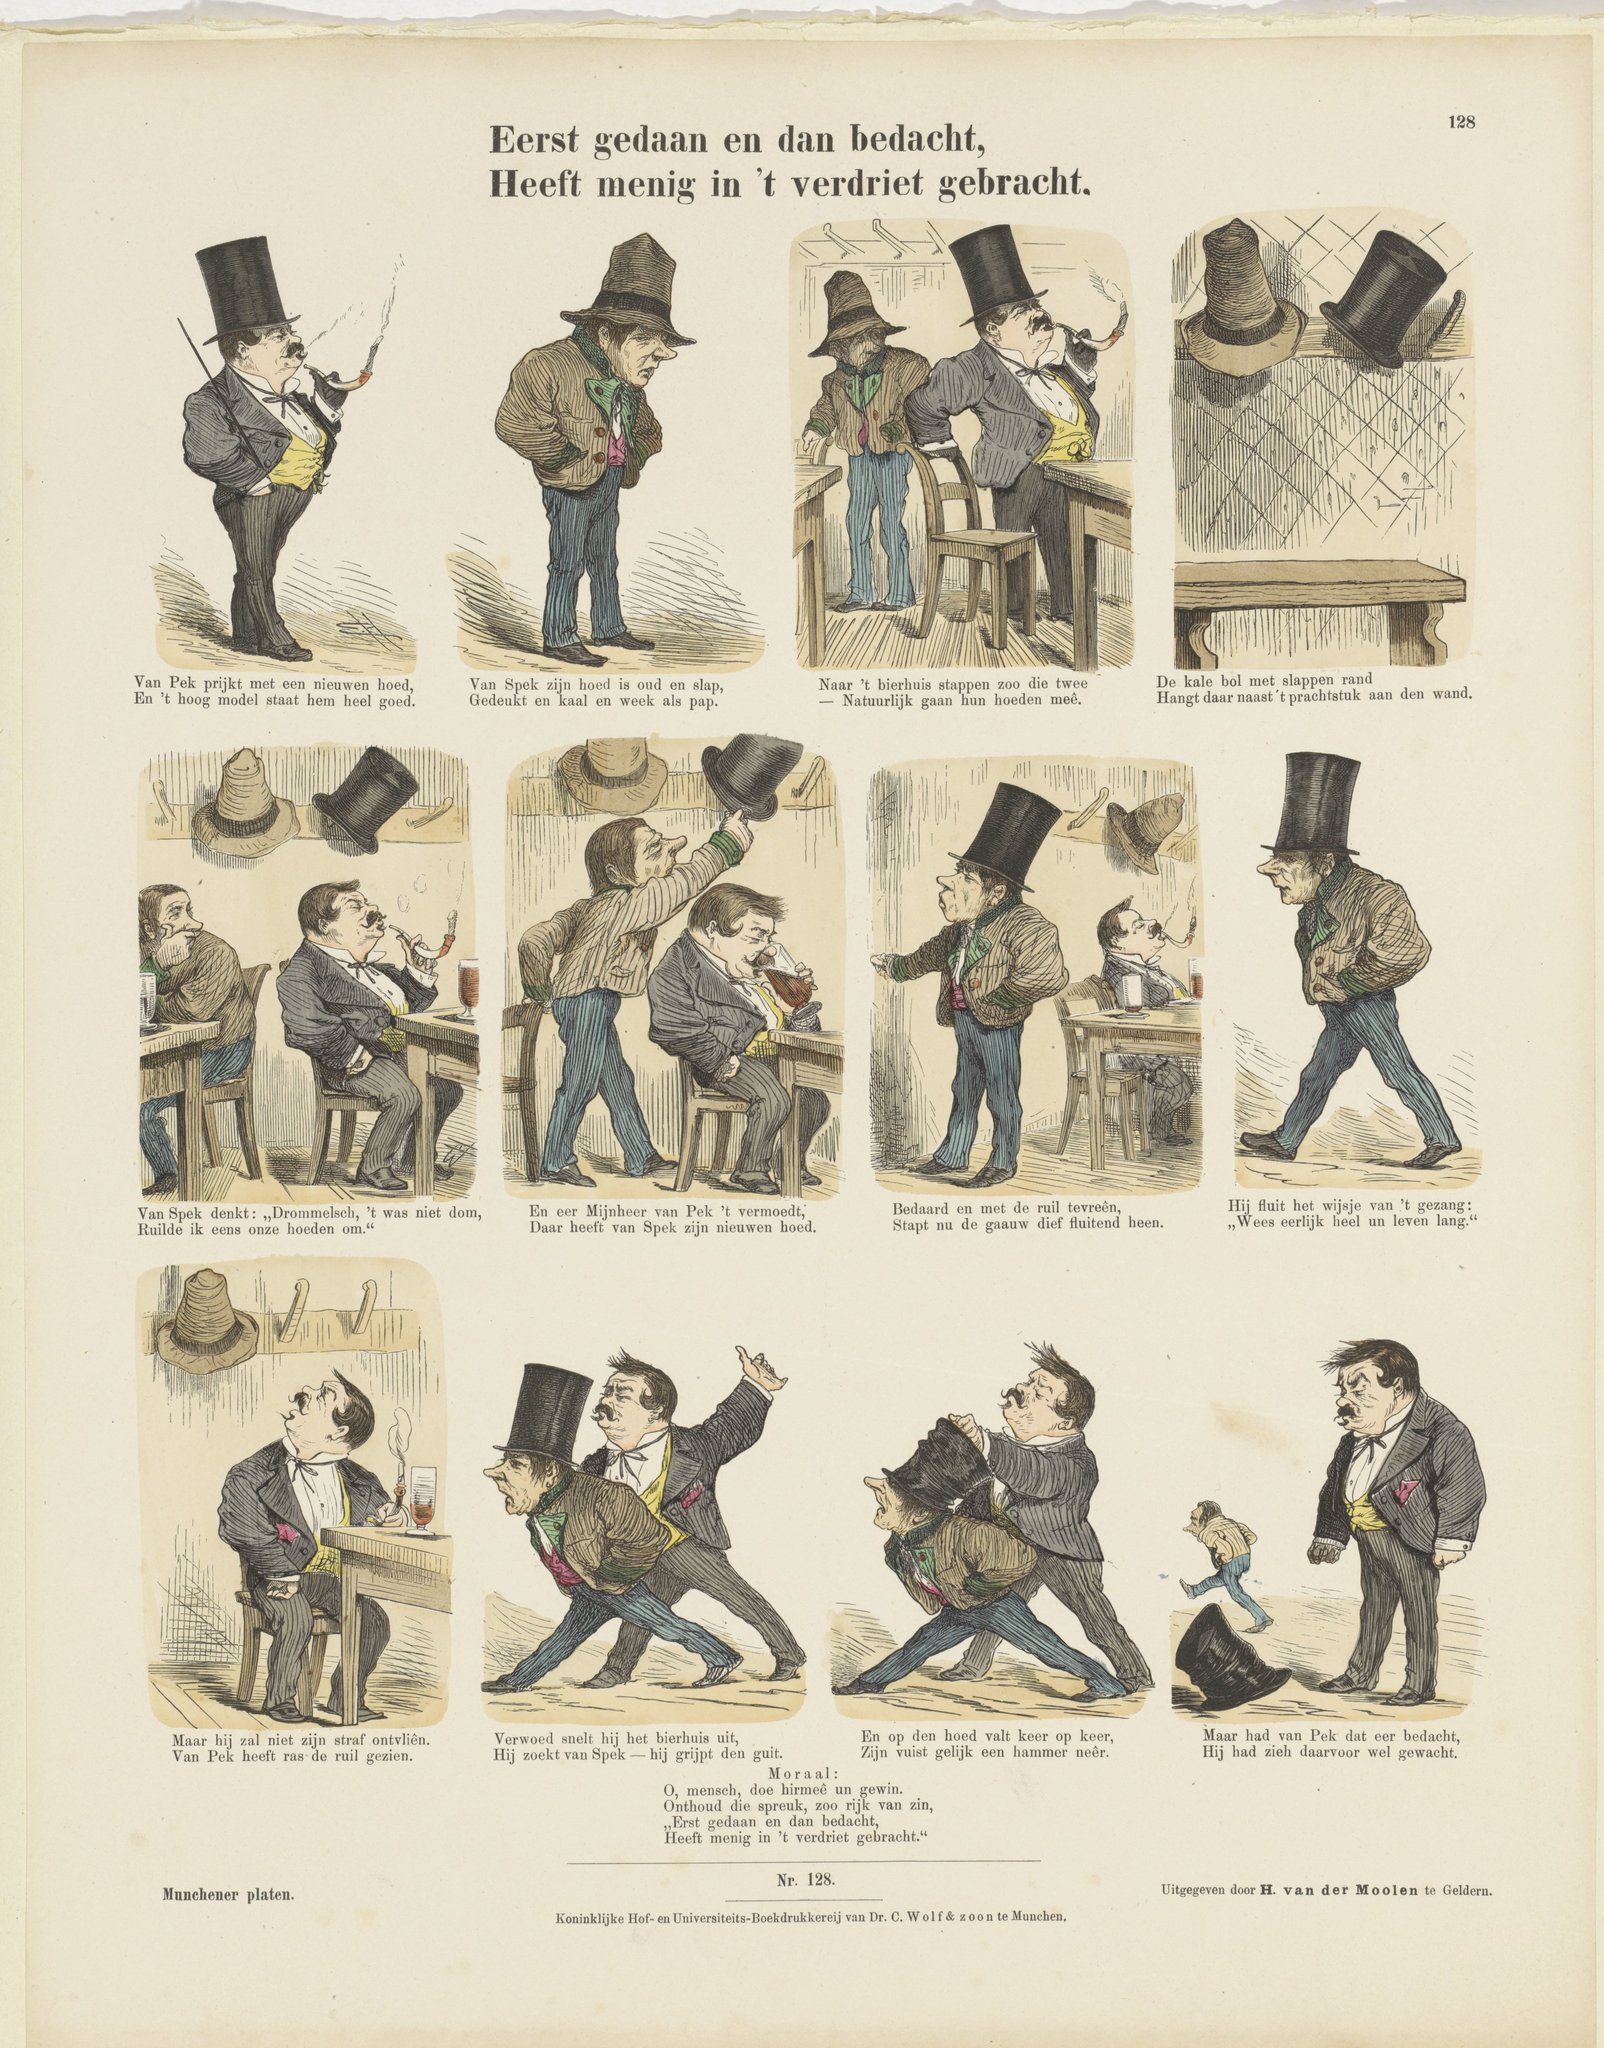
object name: popular print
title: Eerst gedaan en dan bedacht, / Heeft menig in 't verdriet gebracht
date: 1843-1920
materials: paper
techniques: colour, letterpress printing, engraving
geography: germany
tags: inn, coffee-house, public house, etc., robber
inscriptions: collector's mark: Lugt 2760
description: Blad met 12 voorstellingen over meneer Van Spek die de hoed steelt van meneer Van Pek. Onder elke afbeelding een tweeregelig vers. In de ondermarge een vierregelig vers. Genummerd midden onder: Nro. 128. Genummerd rechtsboven: 128.